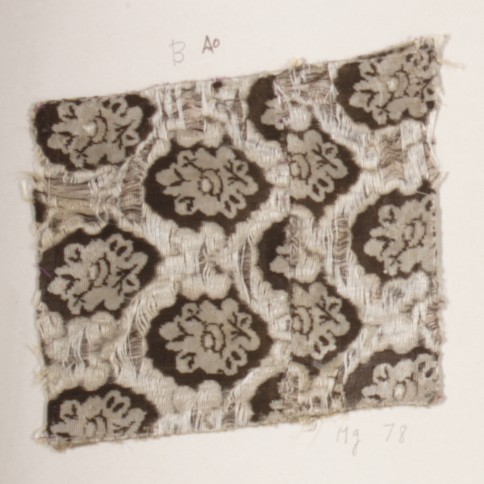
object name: fragment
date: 1701-1800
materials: silk